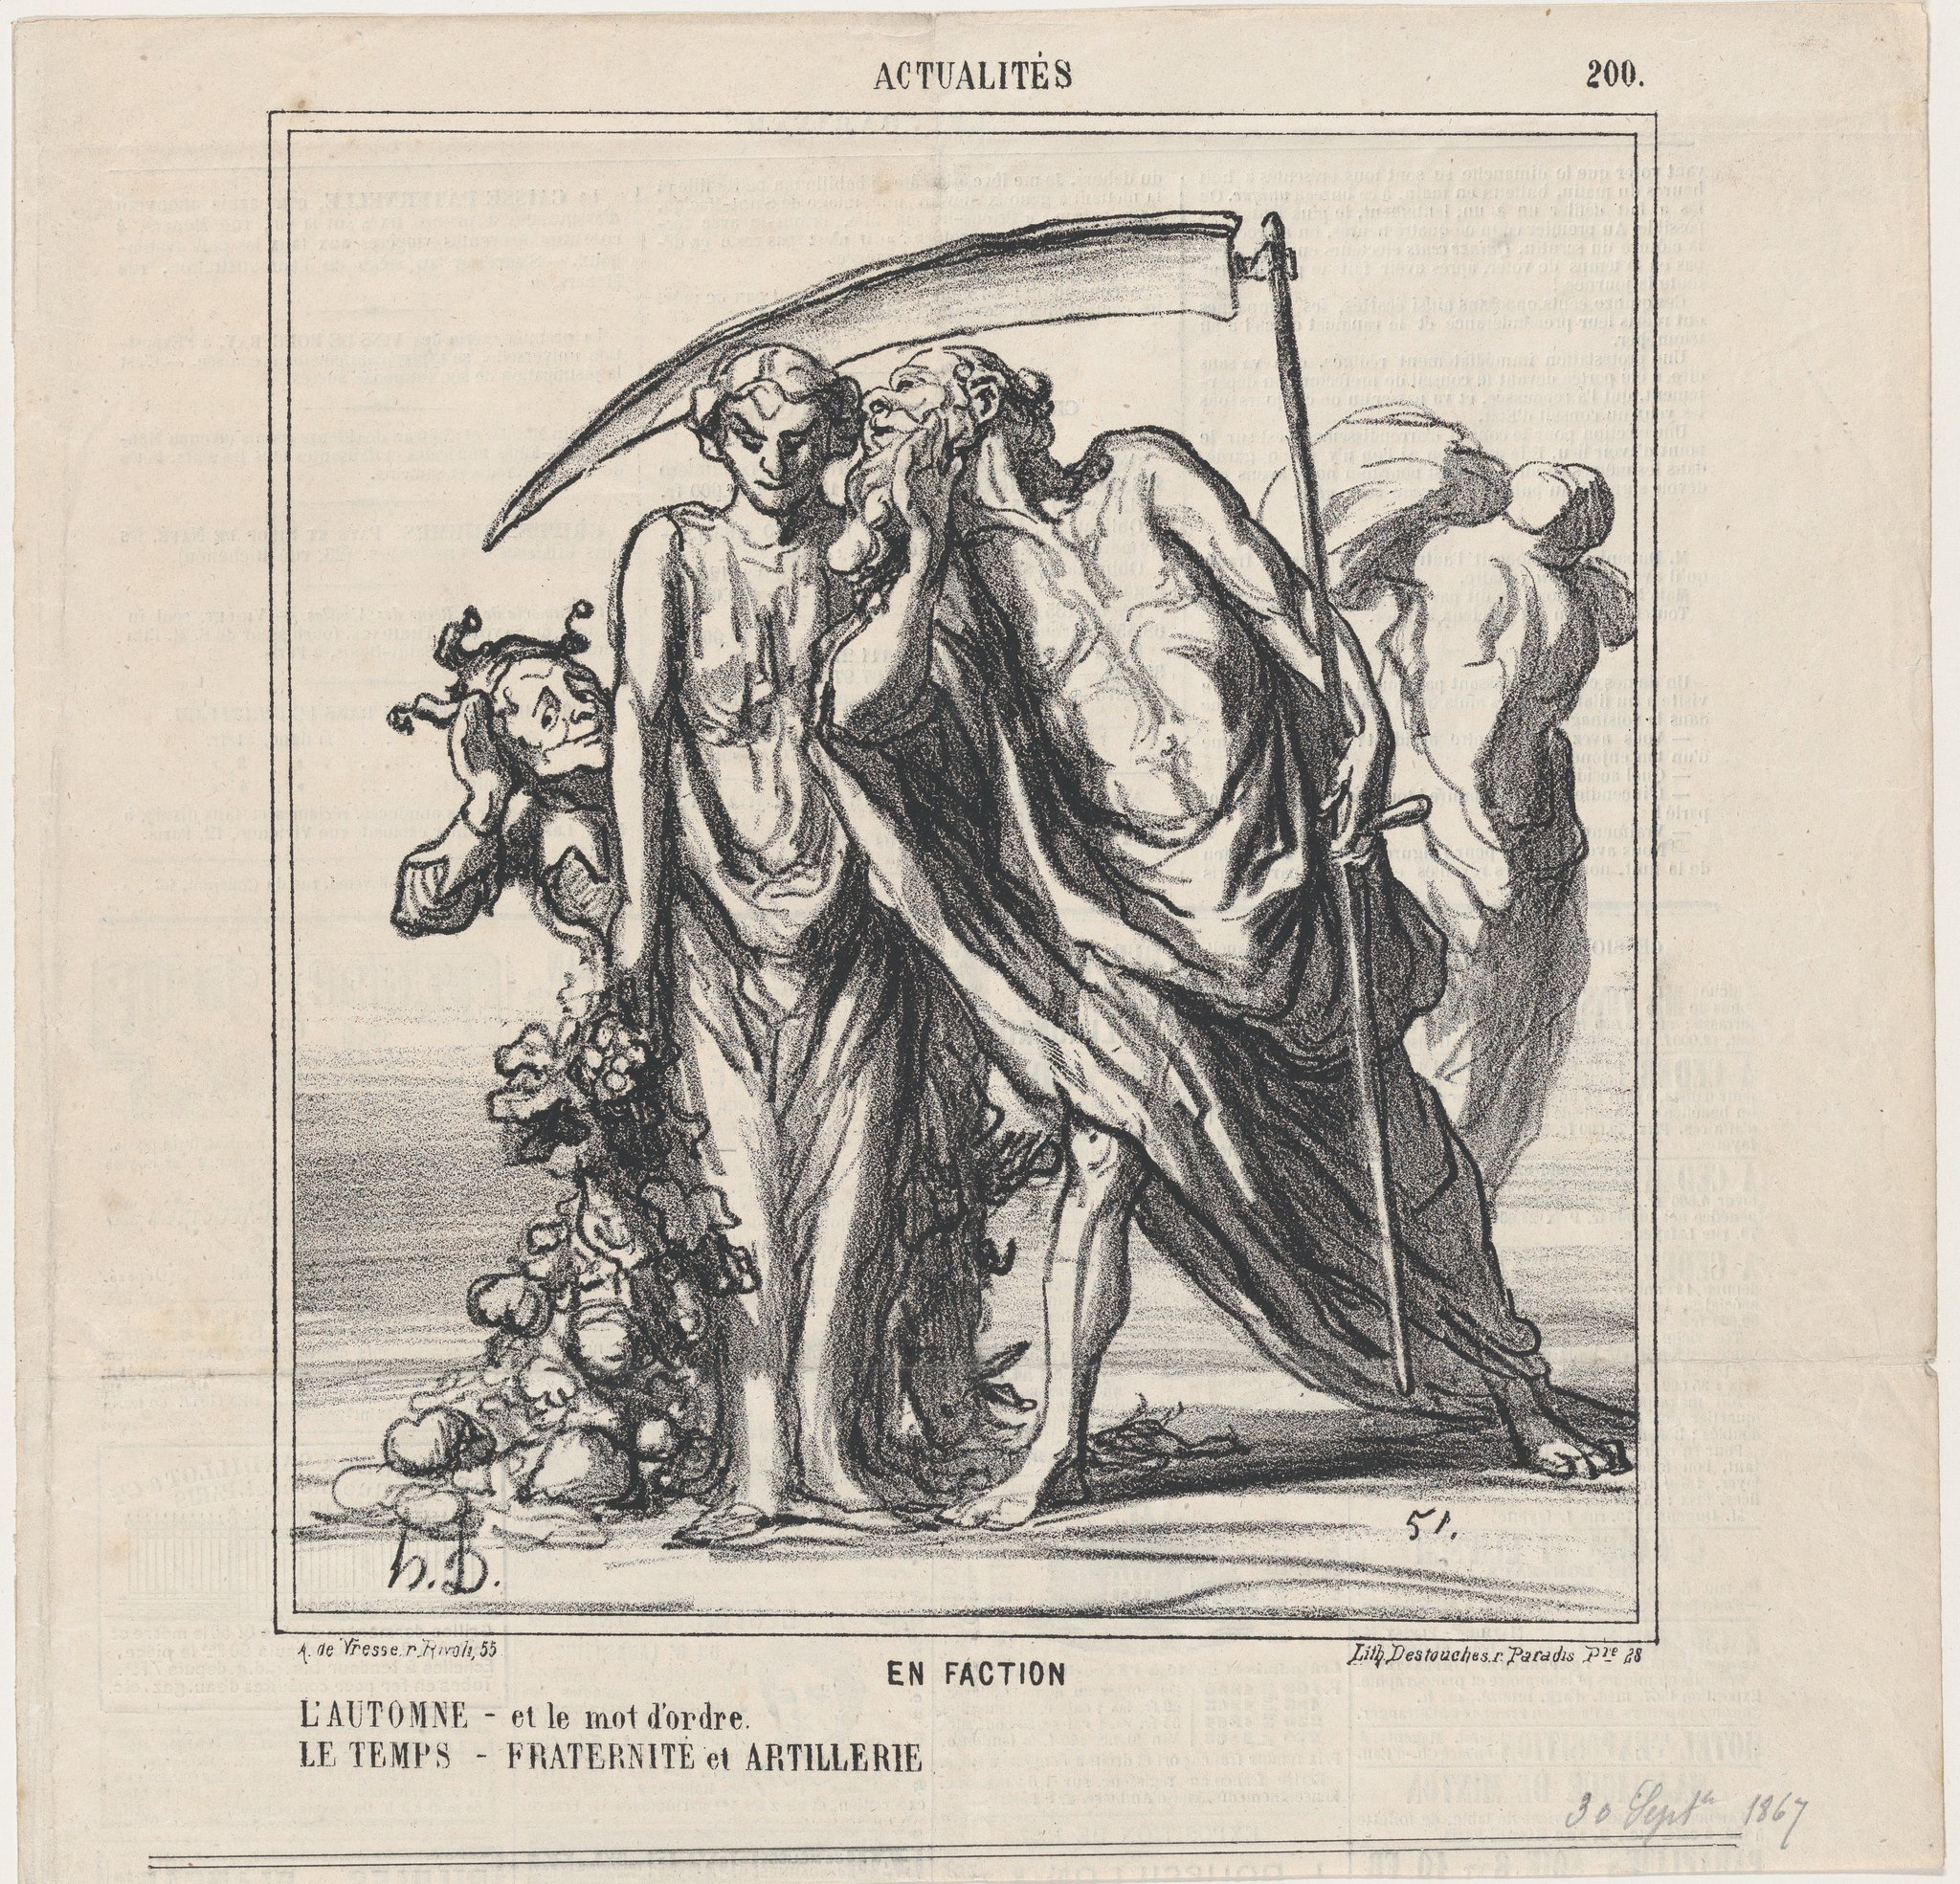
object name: print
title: On Sentry Duty: Autumn –and the password? Time–Fraternity and artillery, from 'News of the day,' published in Le Charivari, September 30, 1867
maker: honoré daumier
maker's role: artist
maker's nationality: french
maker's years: 1808-1879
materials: paper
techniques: lithograph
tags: satire,weapons,men,women